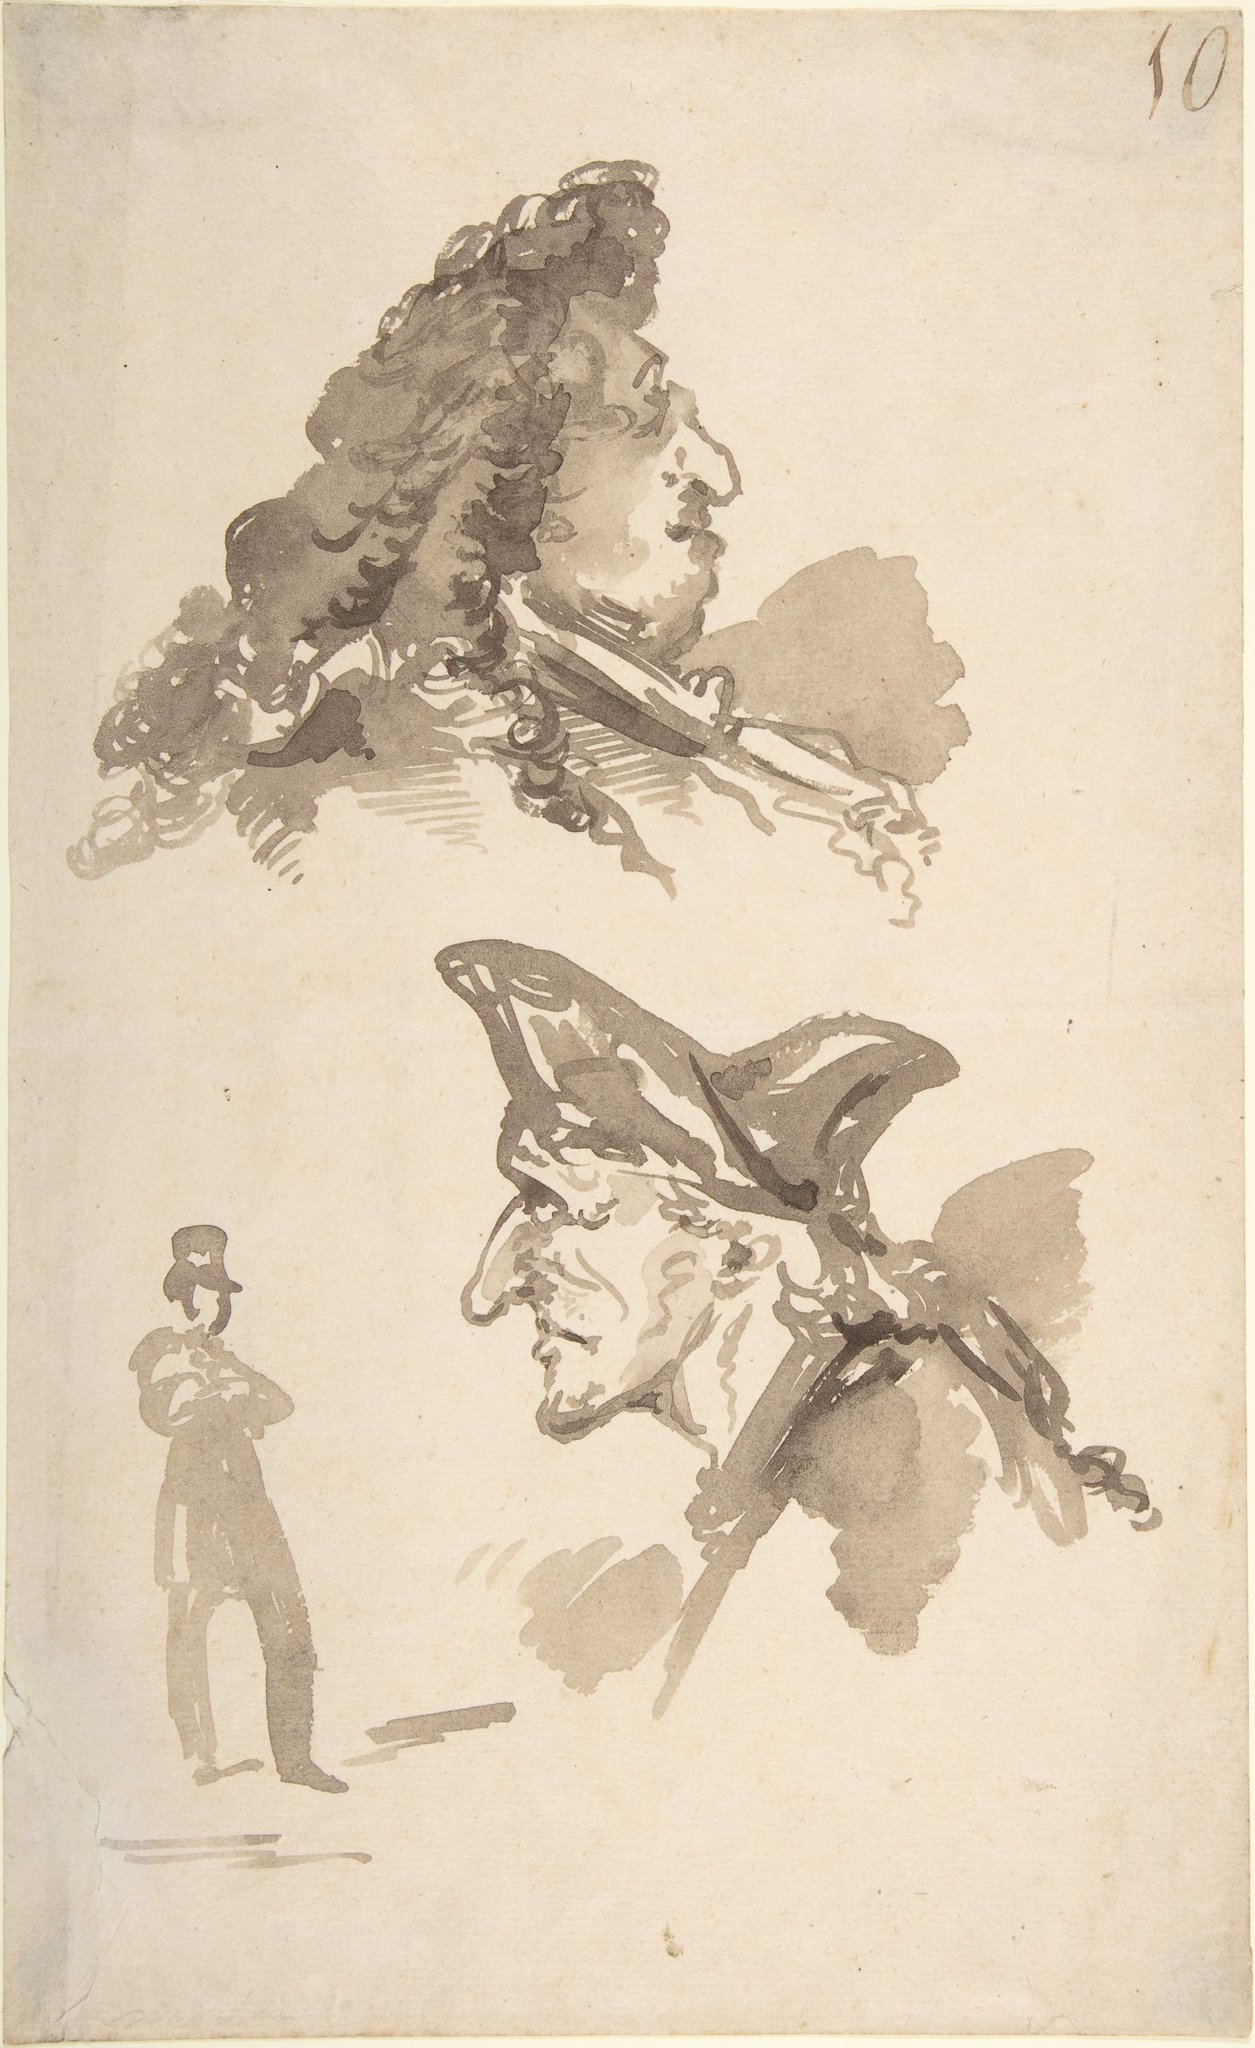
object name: drawing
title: Sheet of Studies: Two Male Heads in Profile and Standing Man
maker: jean-baptiste isabey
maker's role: artist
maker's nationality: french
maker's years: 1767-1855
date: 1767-1866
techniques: brush, wash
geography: france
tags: heads,men,profiles